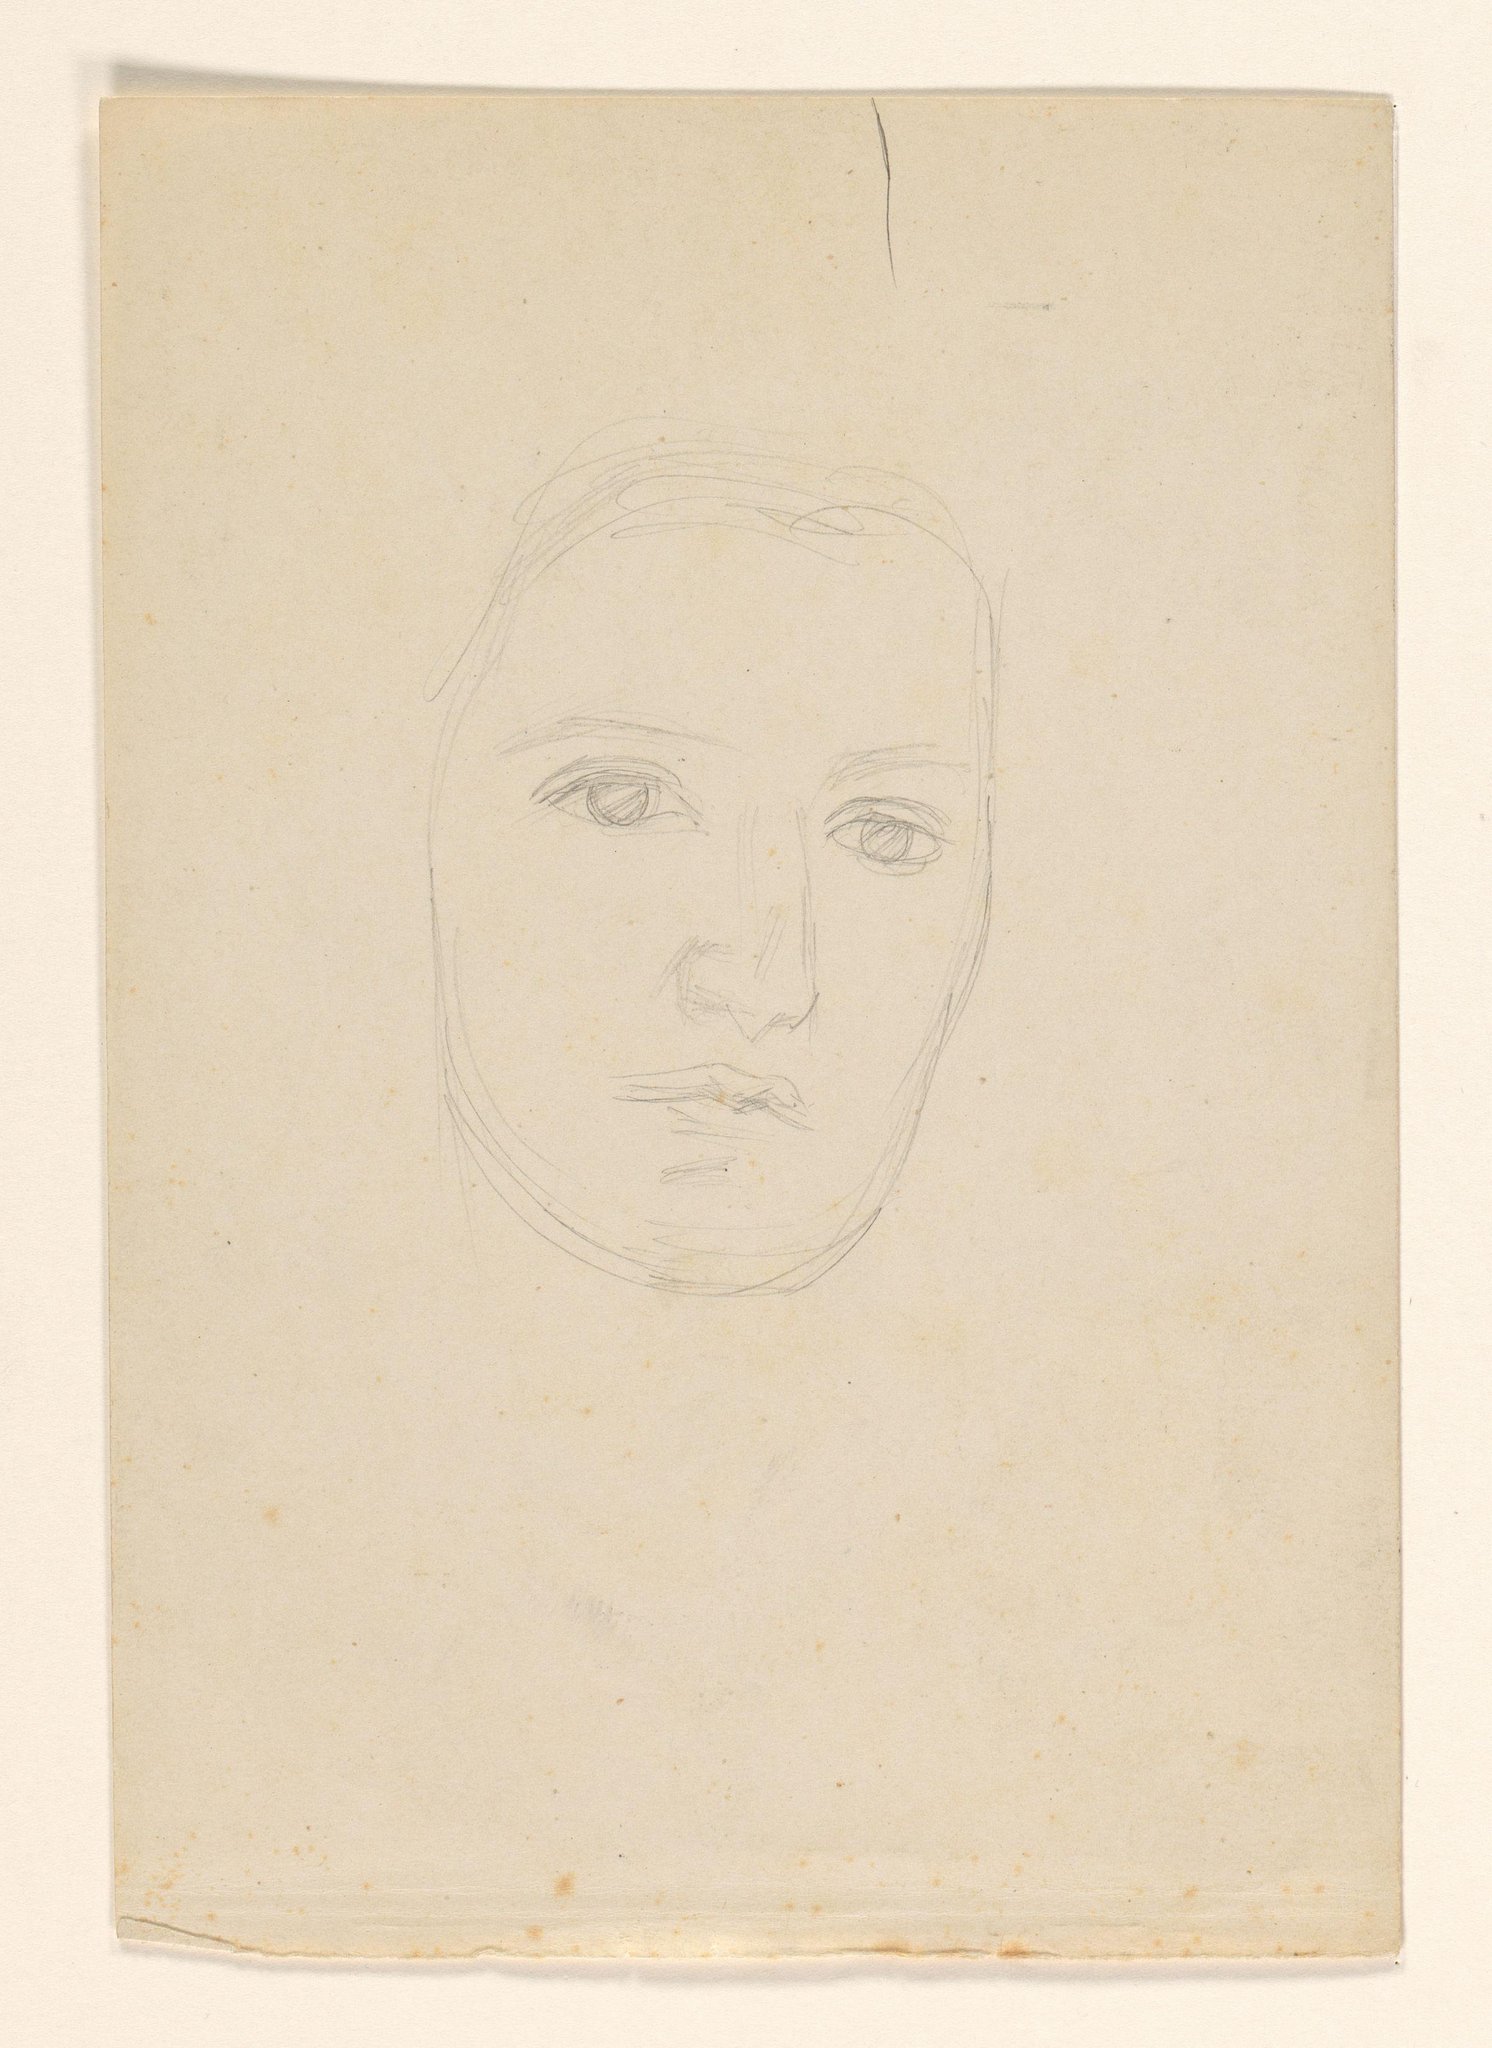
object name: drawing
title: Schetsblad met vrouwelijk gezicht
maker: august allebé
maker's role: draughtsman, print maker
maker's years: 1838-1927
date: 1848-1927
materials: paper, pencil